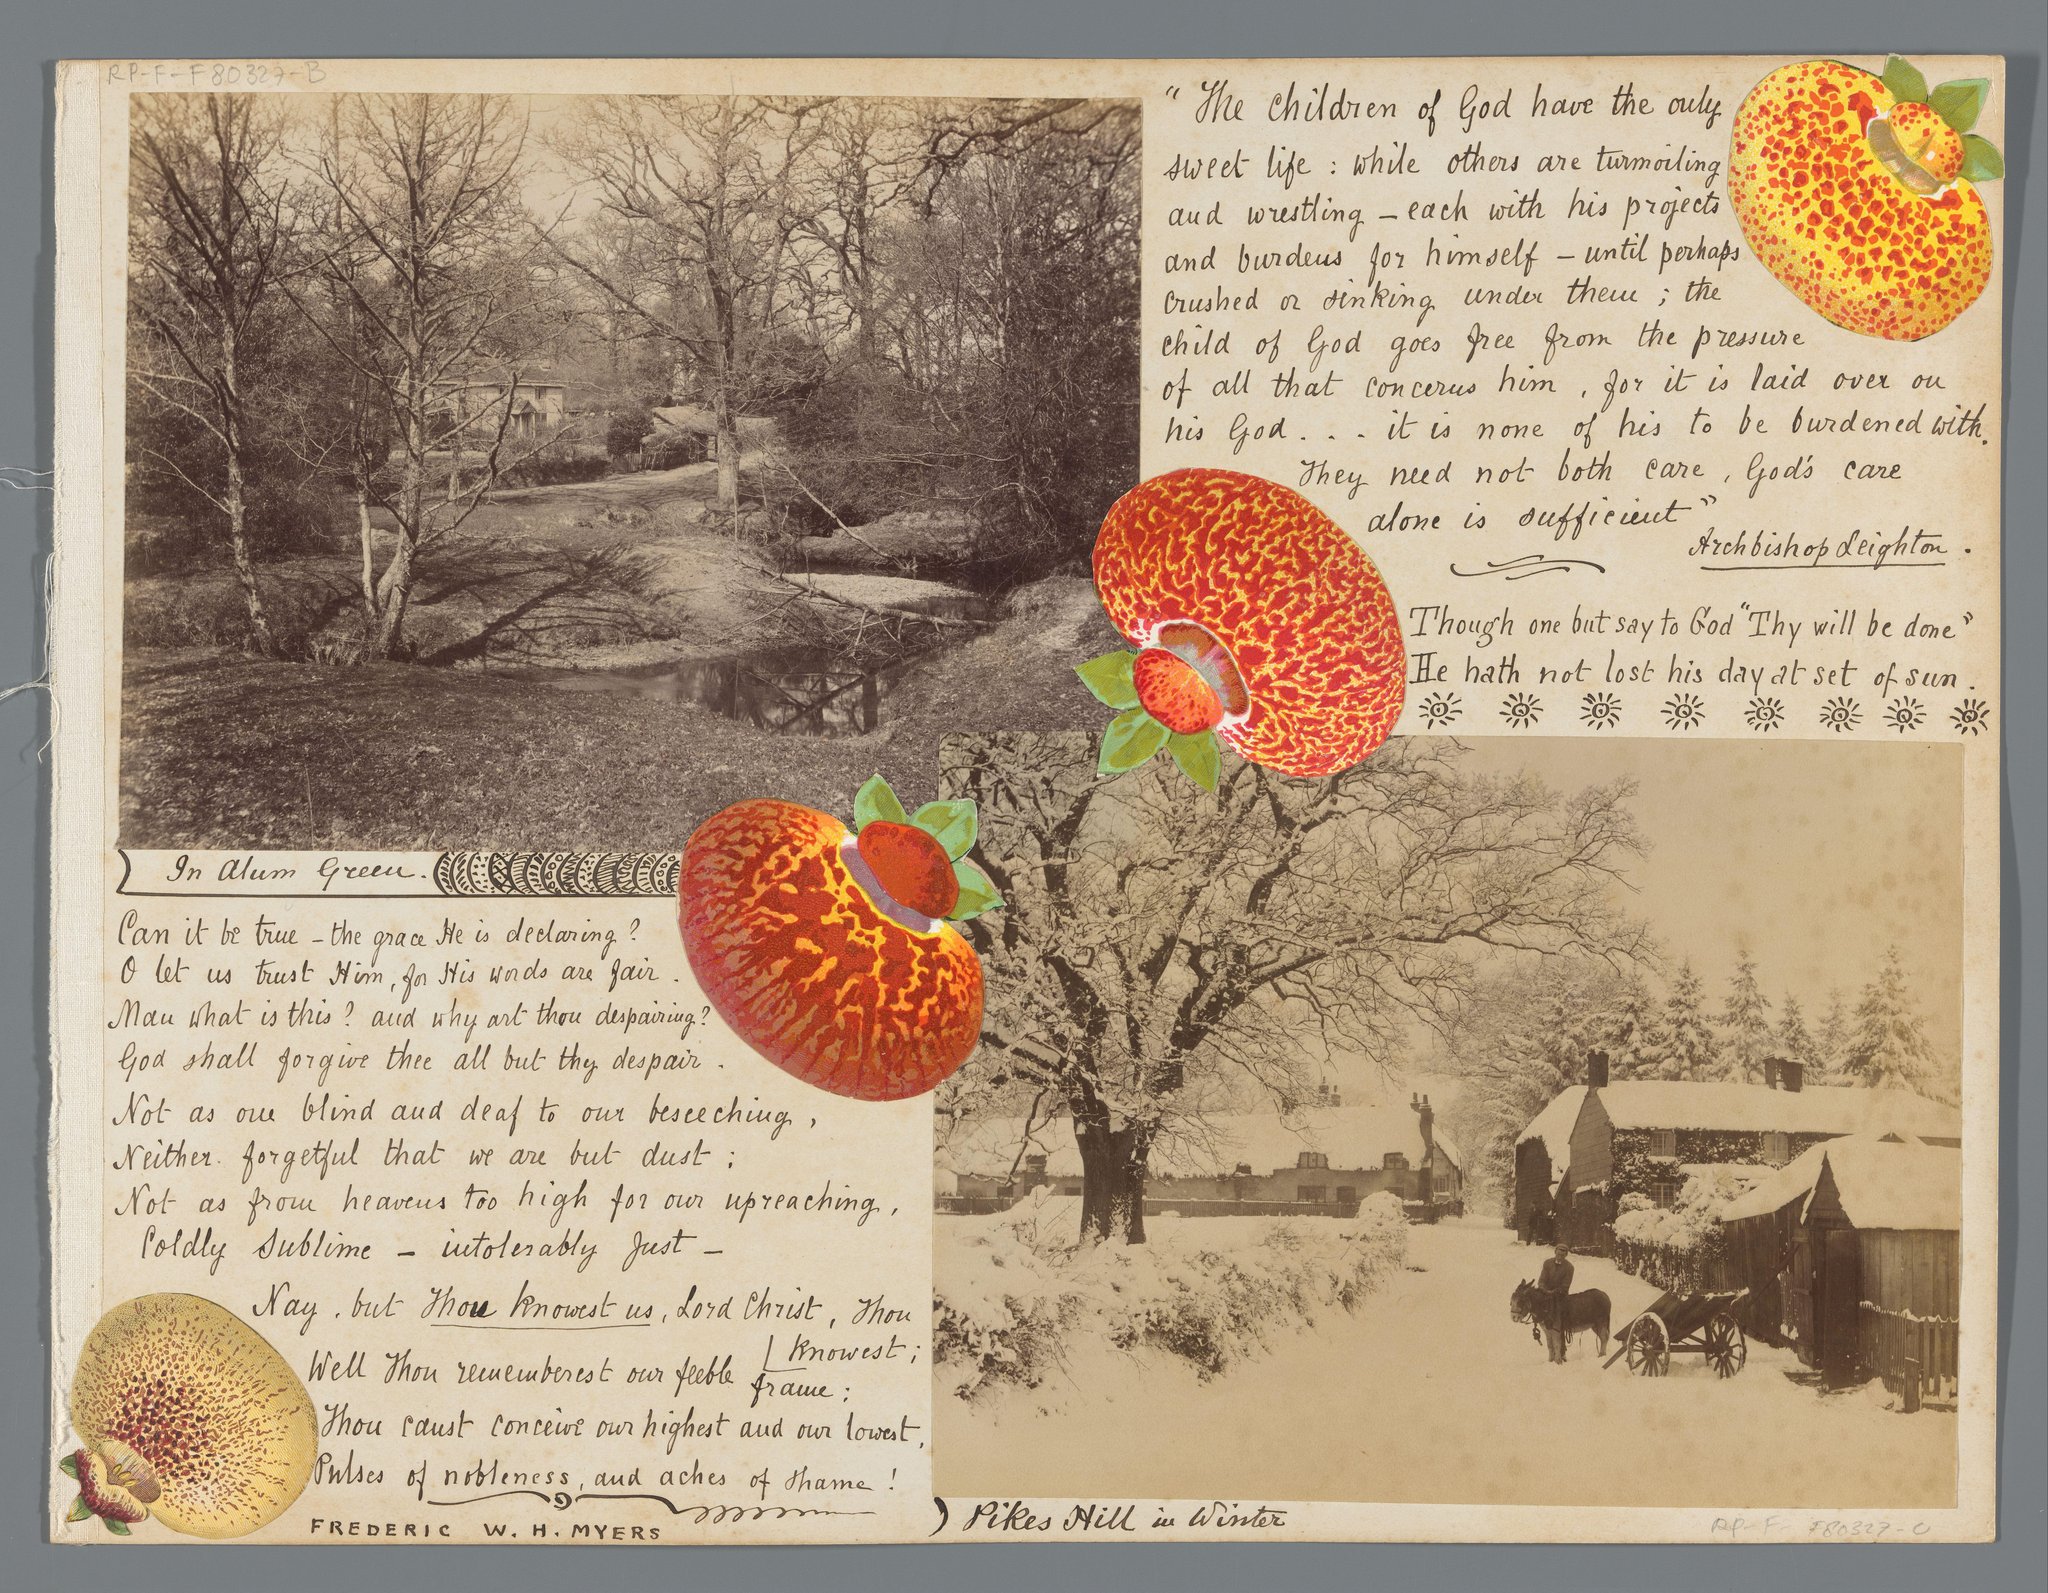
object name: print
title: Bosgezicht in Allum Green, en besneeuwd winterlandschap in Pikes Hill, omringd door orchideeën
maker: Anonymous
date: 1855-1900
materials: cardboard, paper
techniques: albumen print, lithograph, writing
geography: england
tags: village, forest, wood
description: Dichtregels van Frederic W. H. Myers en aartsbisschop Robert Leighton van Glasgow.